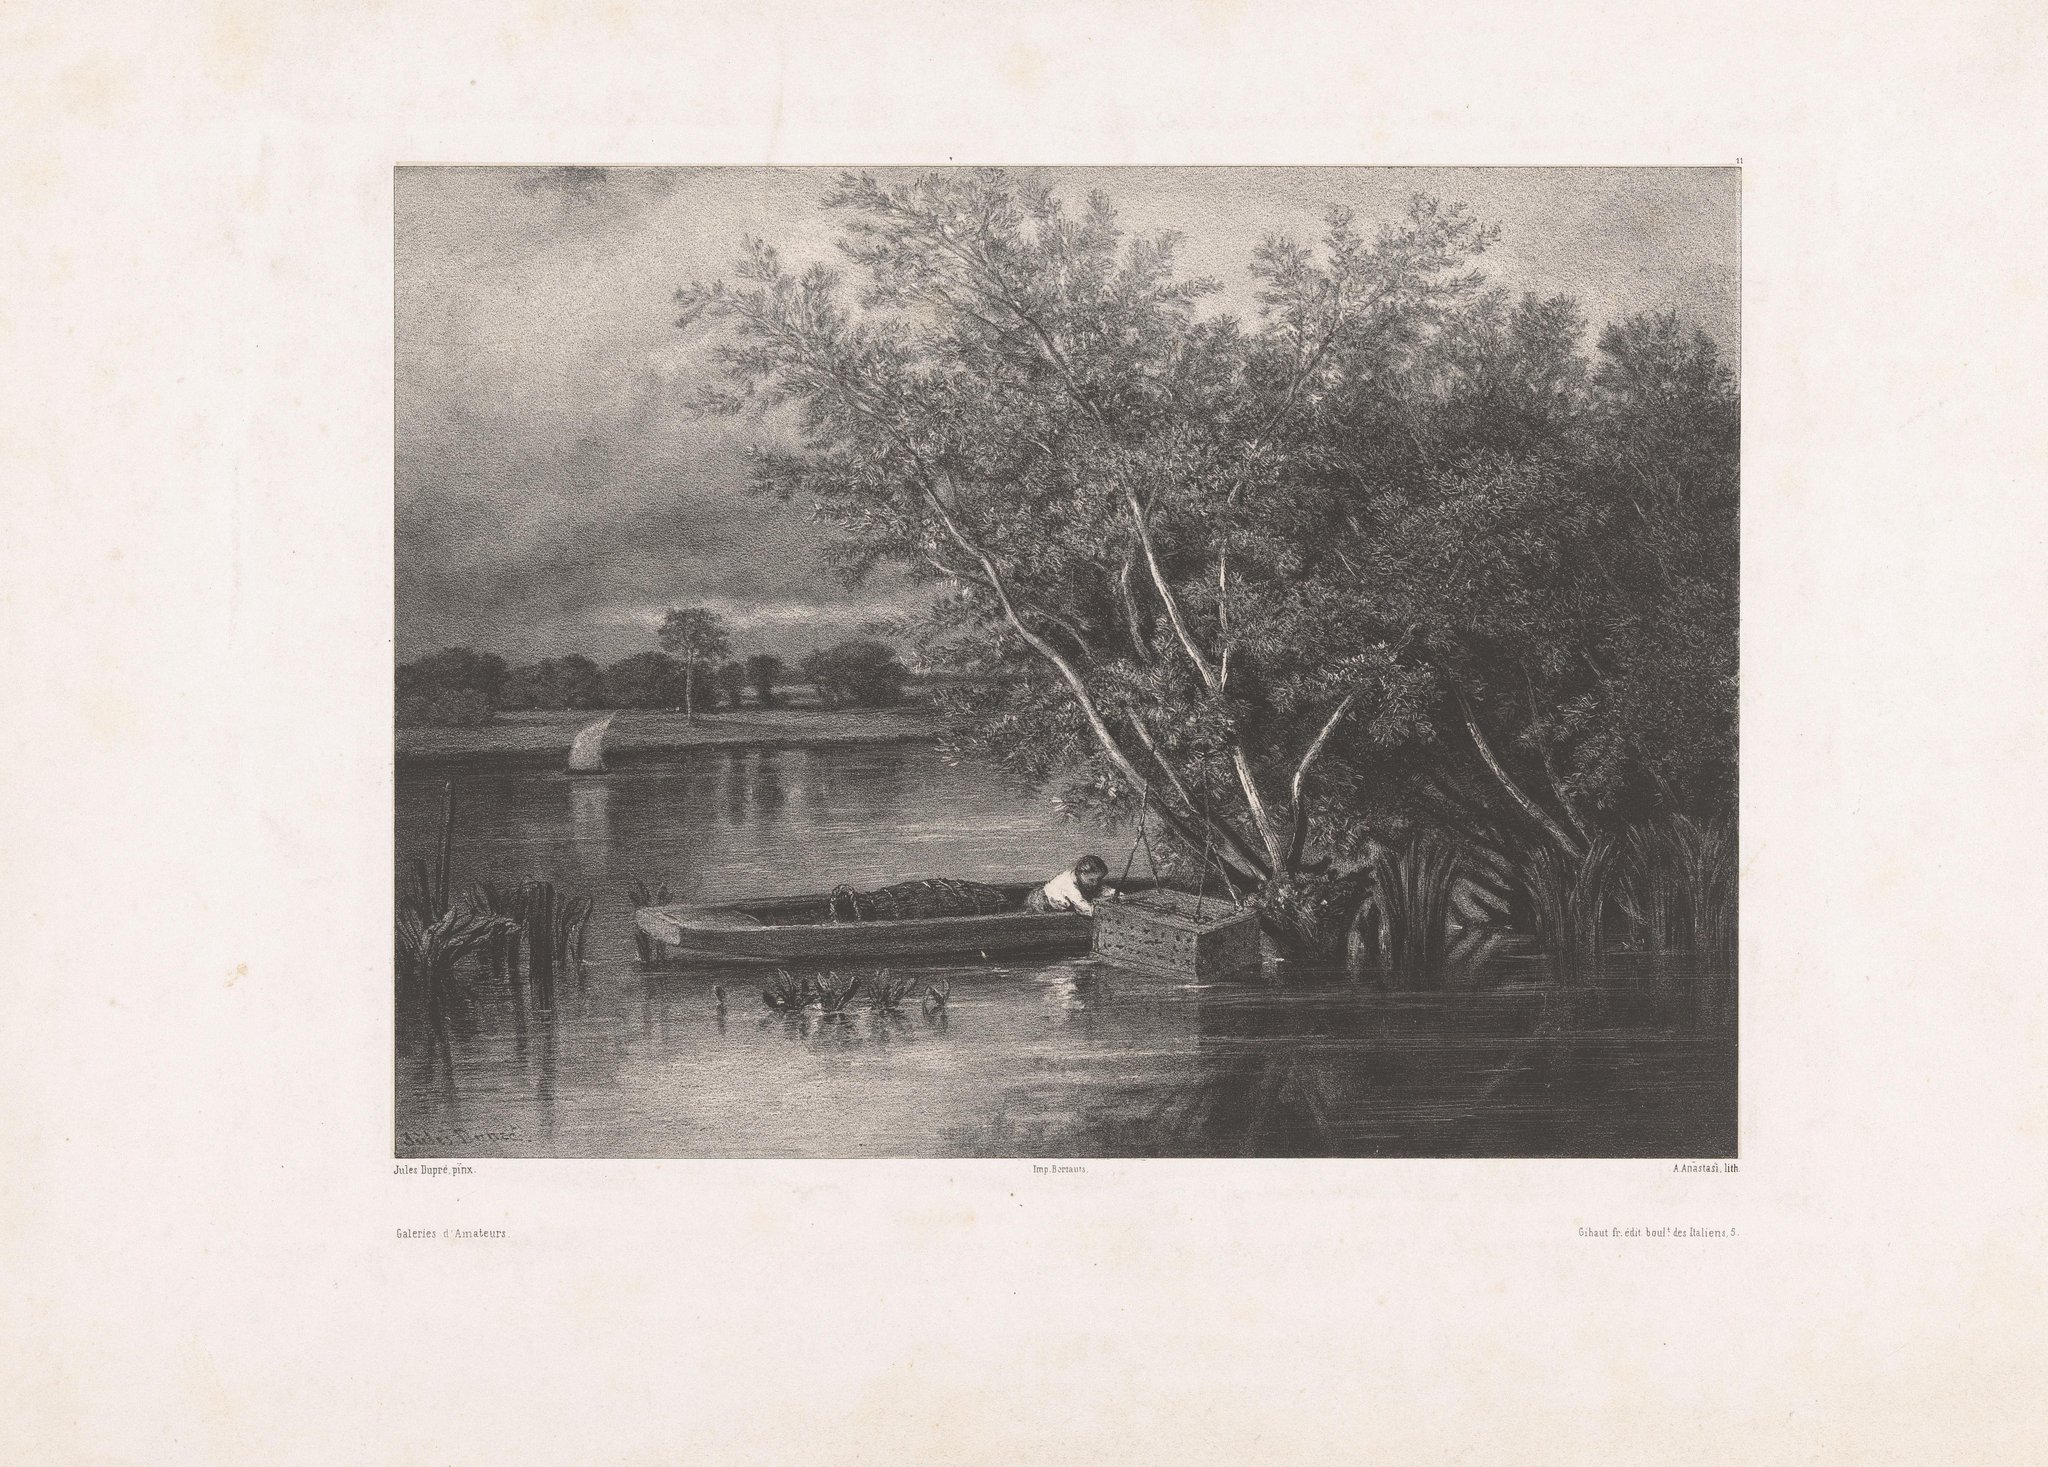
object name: print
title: Rivierlandschap met visser in boot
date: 1849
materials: paper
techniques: lithograph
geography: paris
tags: commercial fishery, fishing net, river, rowing-boat, canoe, etc., fisherman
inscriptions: collector's mark: Lugt 2228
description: Een visser bekijkt vanuit zijn boot op het water de vangst in zijn kaar.